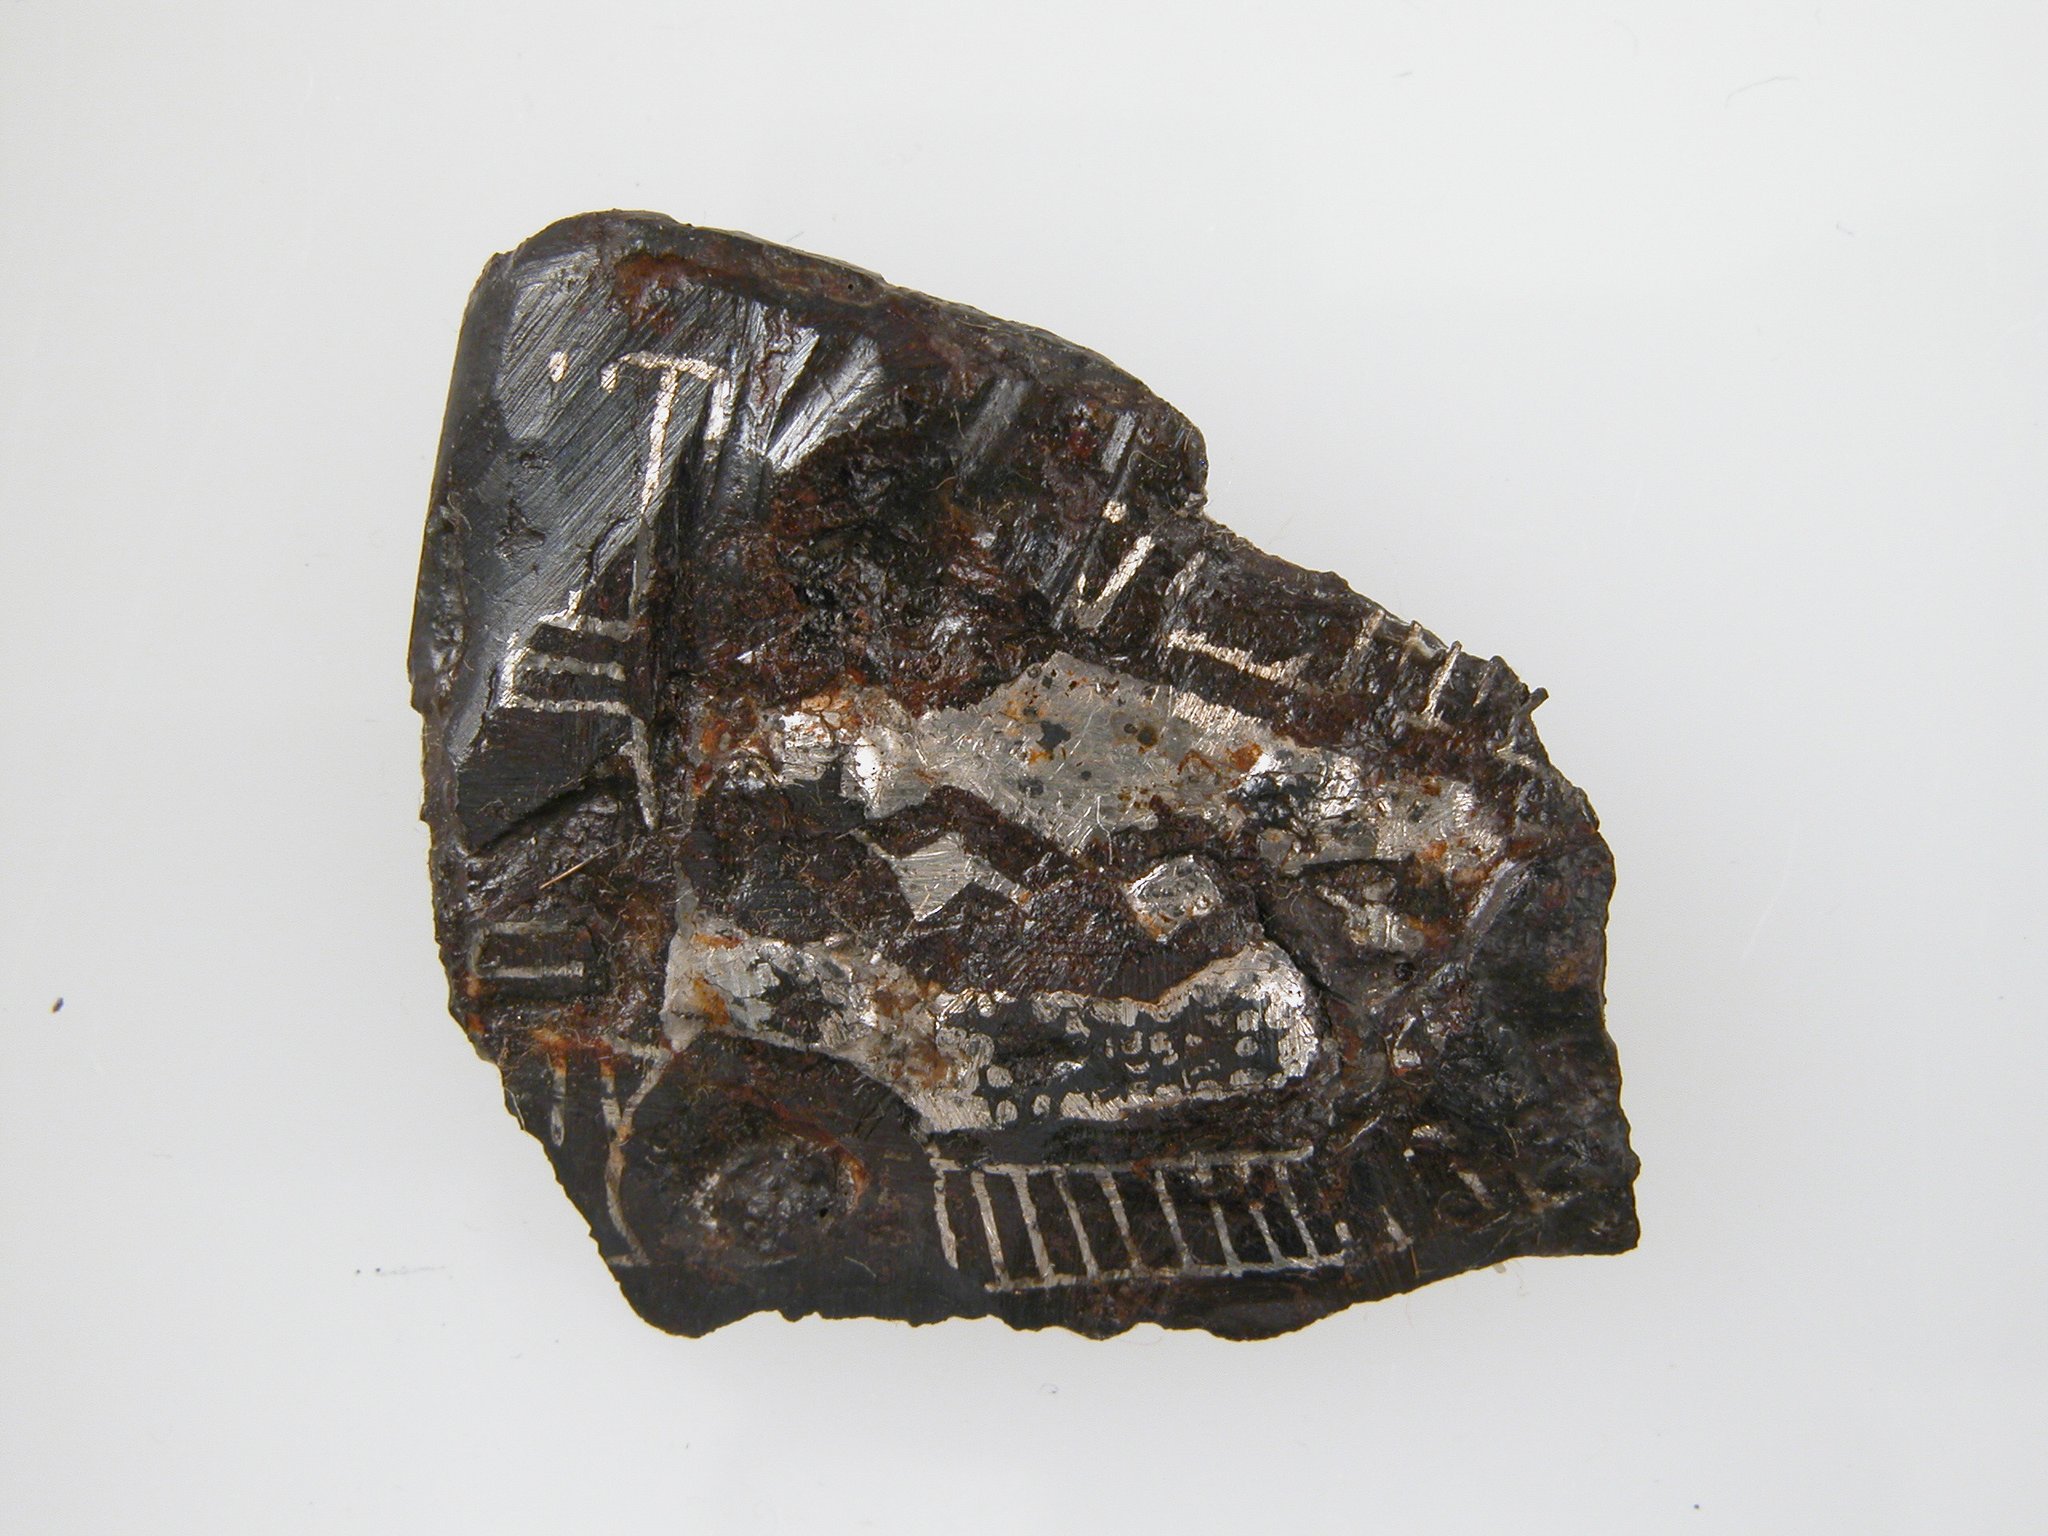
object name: belt plate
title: Belt Plate Fragment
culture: frankish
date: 301-700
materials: iron, silver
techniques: inlay